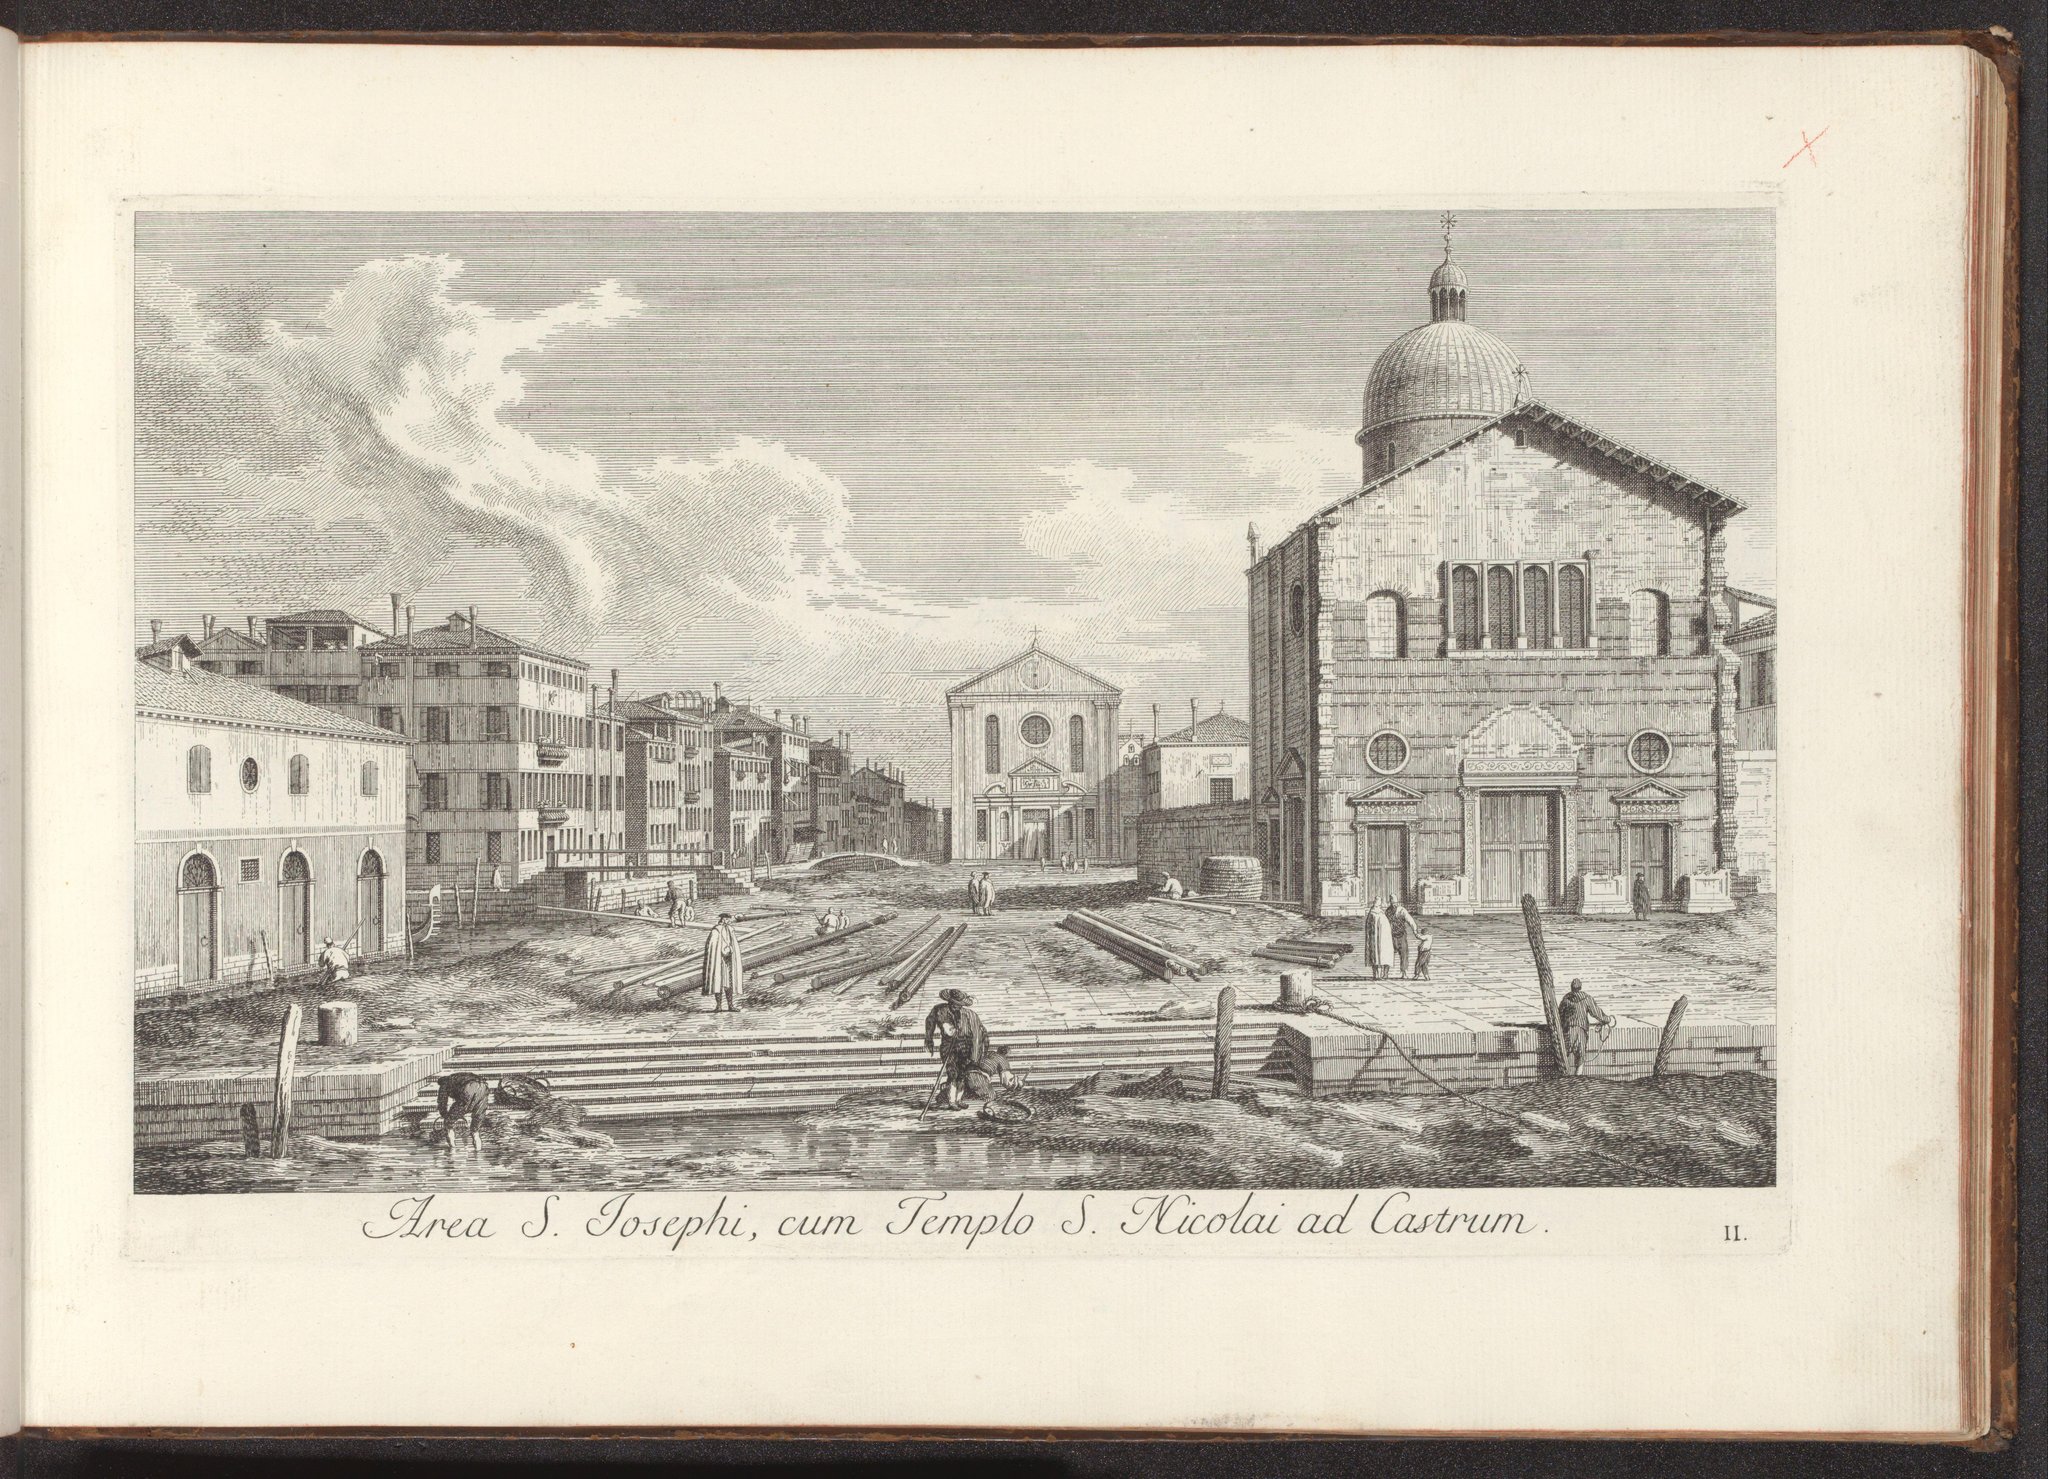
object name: album leaf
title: Gezichten op gebouwen en pleinen in Venetië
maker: antonio visentini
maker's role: draughtsman, print maker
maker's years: 1688-1782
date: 1742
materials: paper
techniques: etching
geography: venice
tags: city-view, and landscape with man-made constructions, canal, church (exterior)